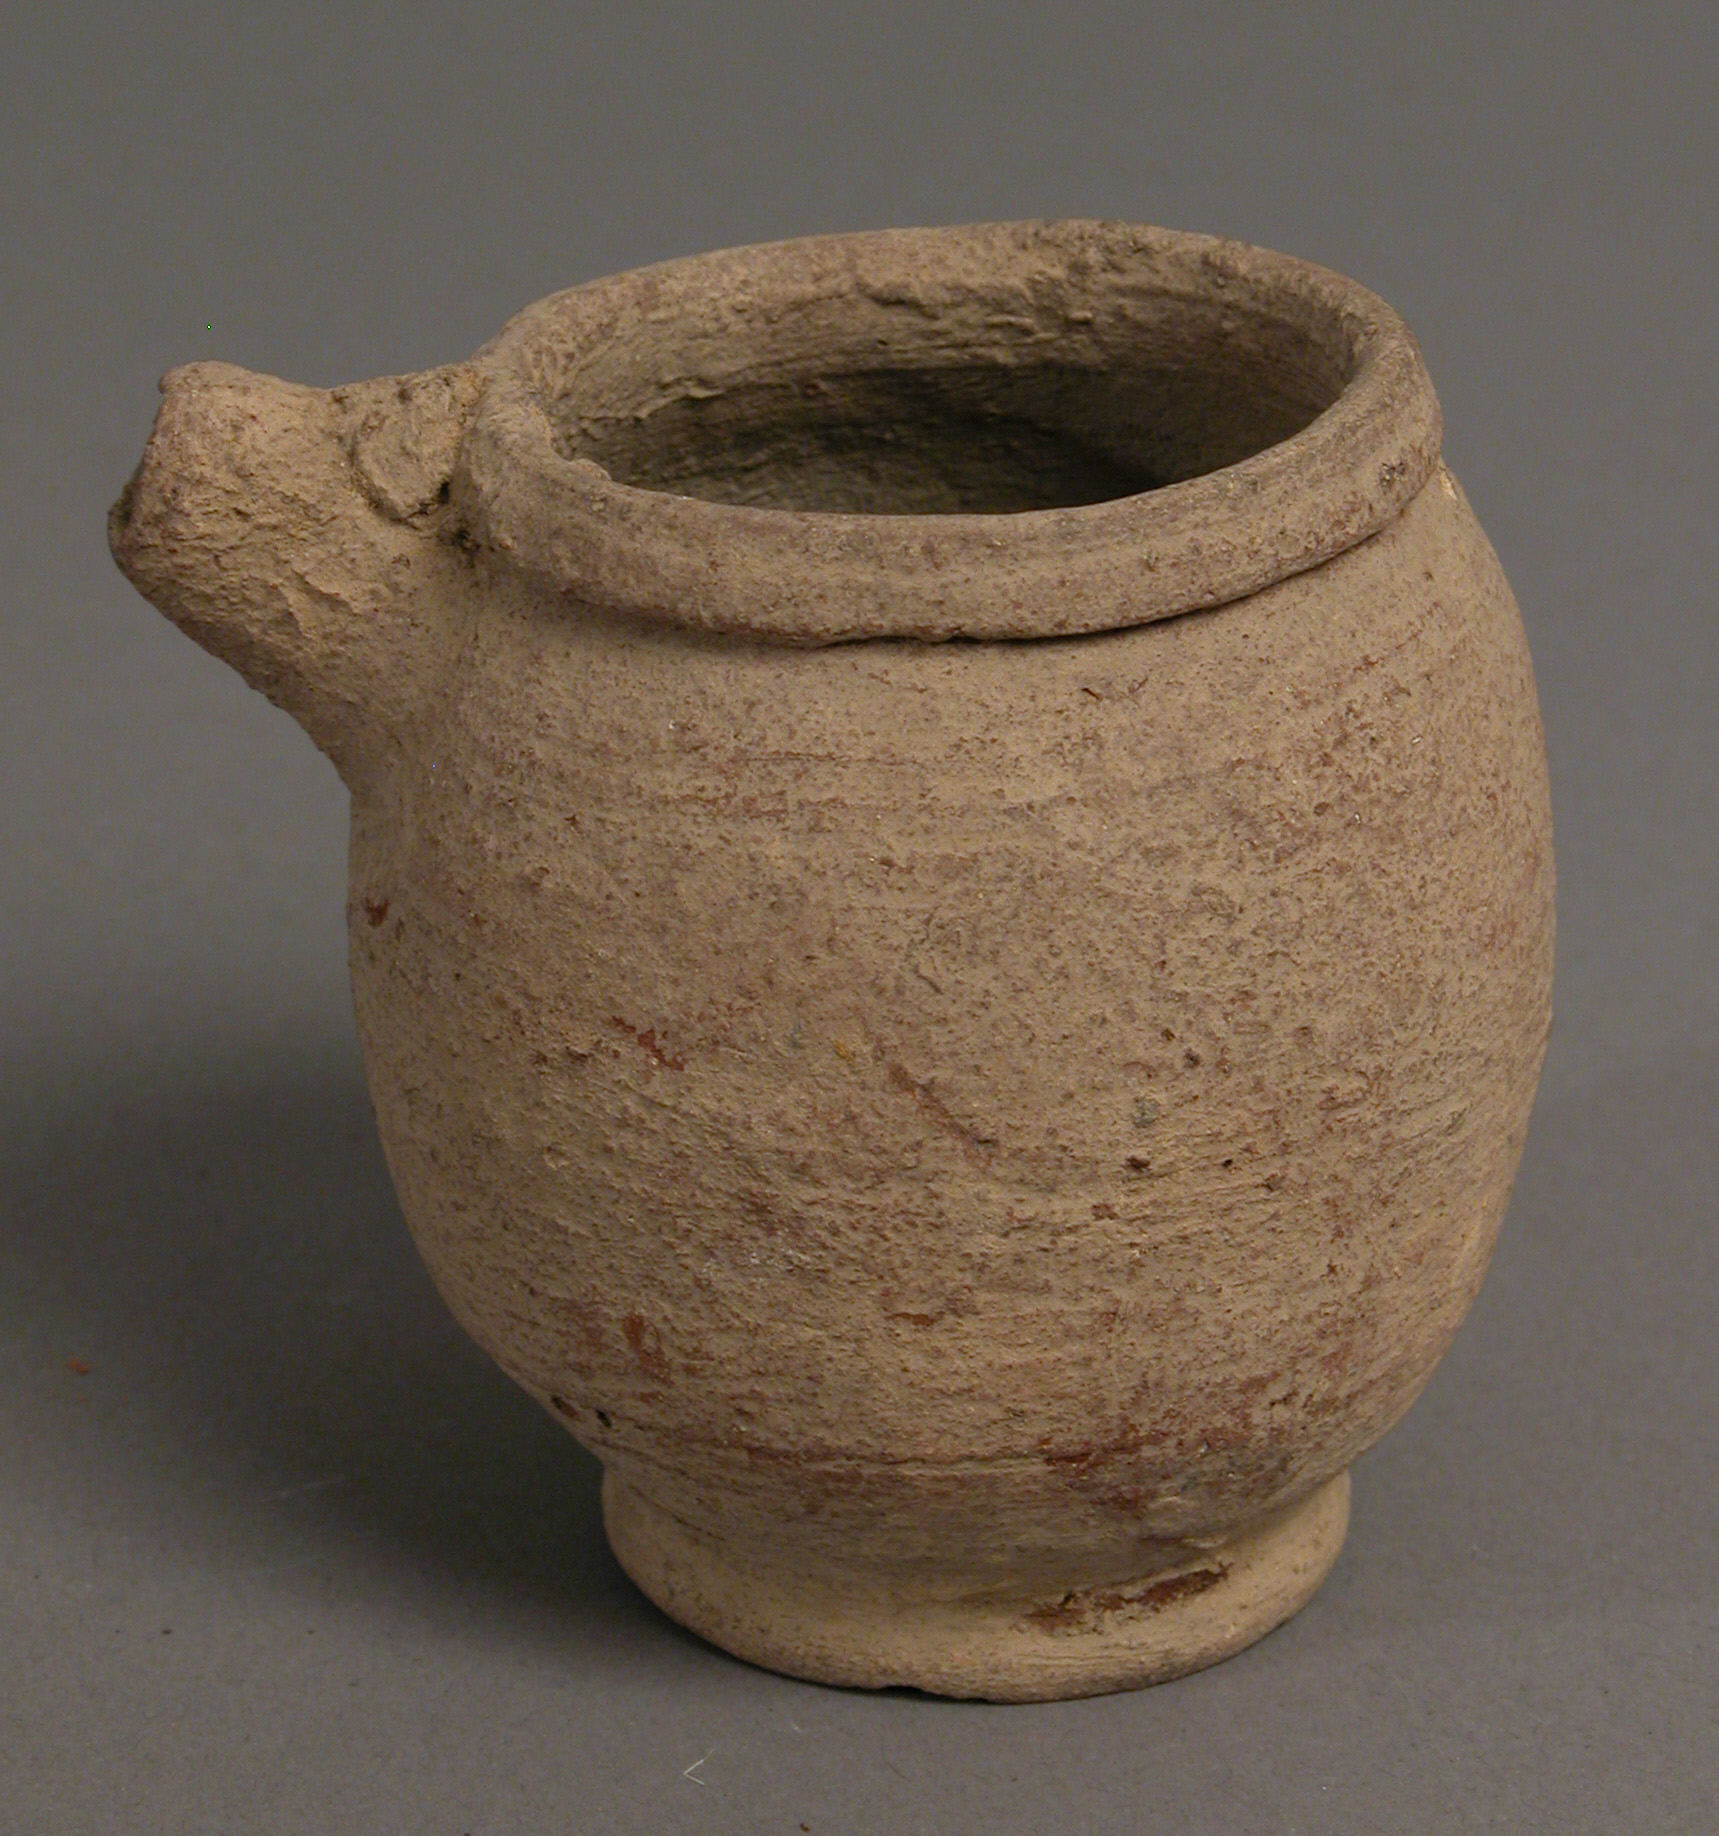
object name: pot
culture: coptic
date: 301-700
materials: earthenware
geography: egypt